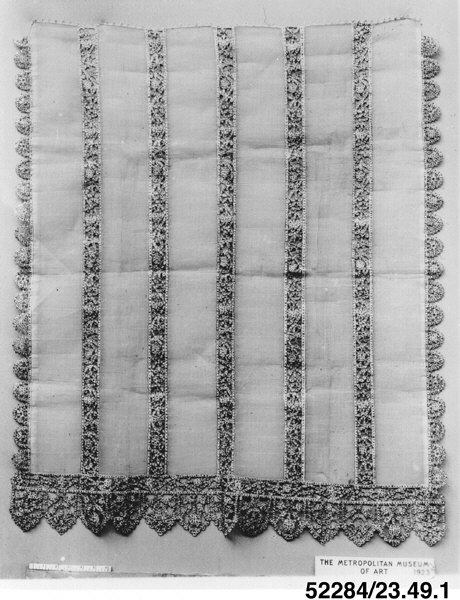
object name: apron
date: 1601-1633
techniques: embroidery